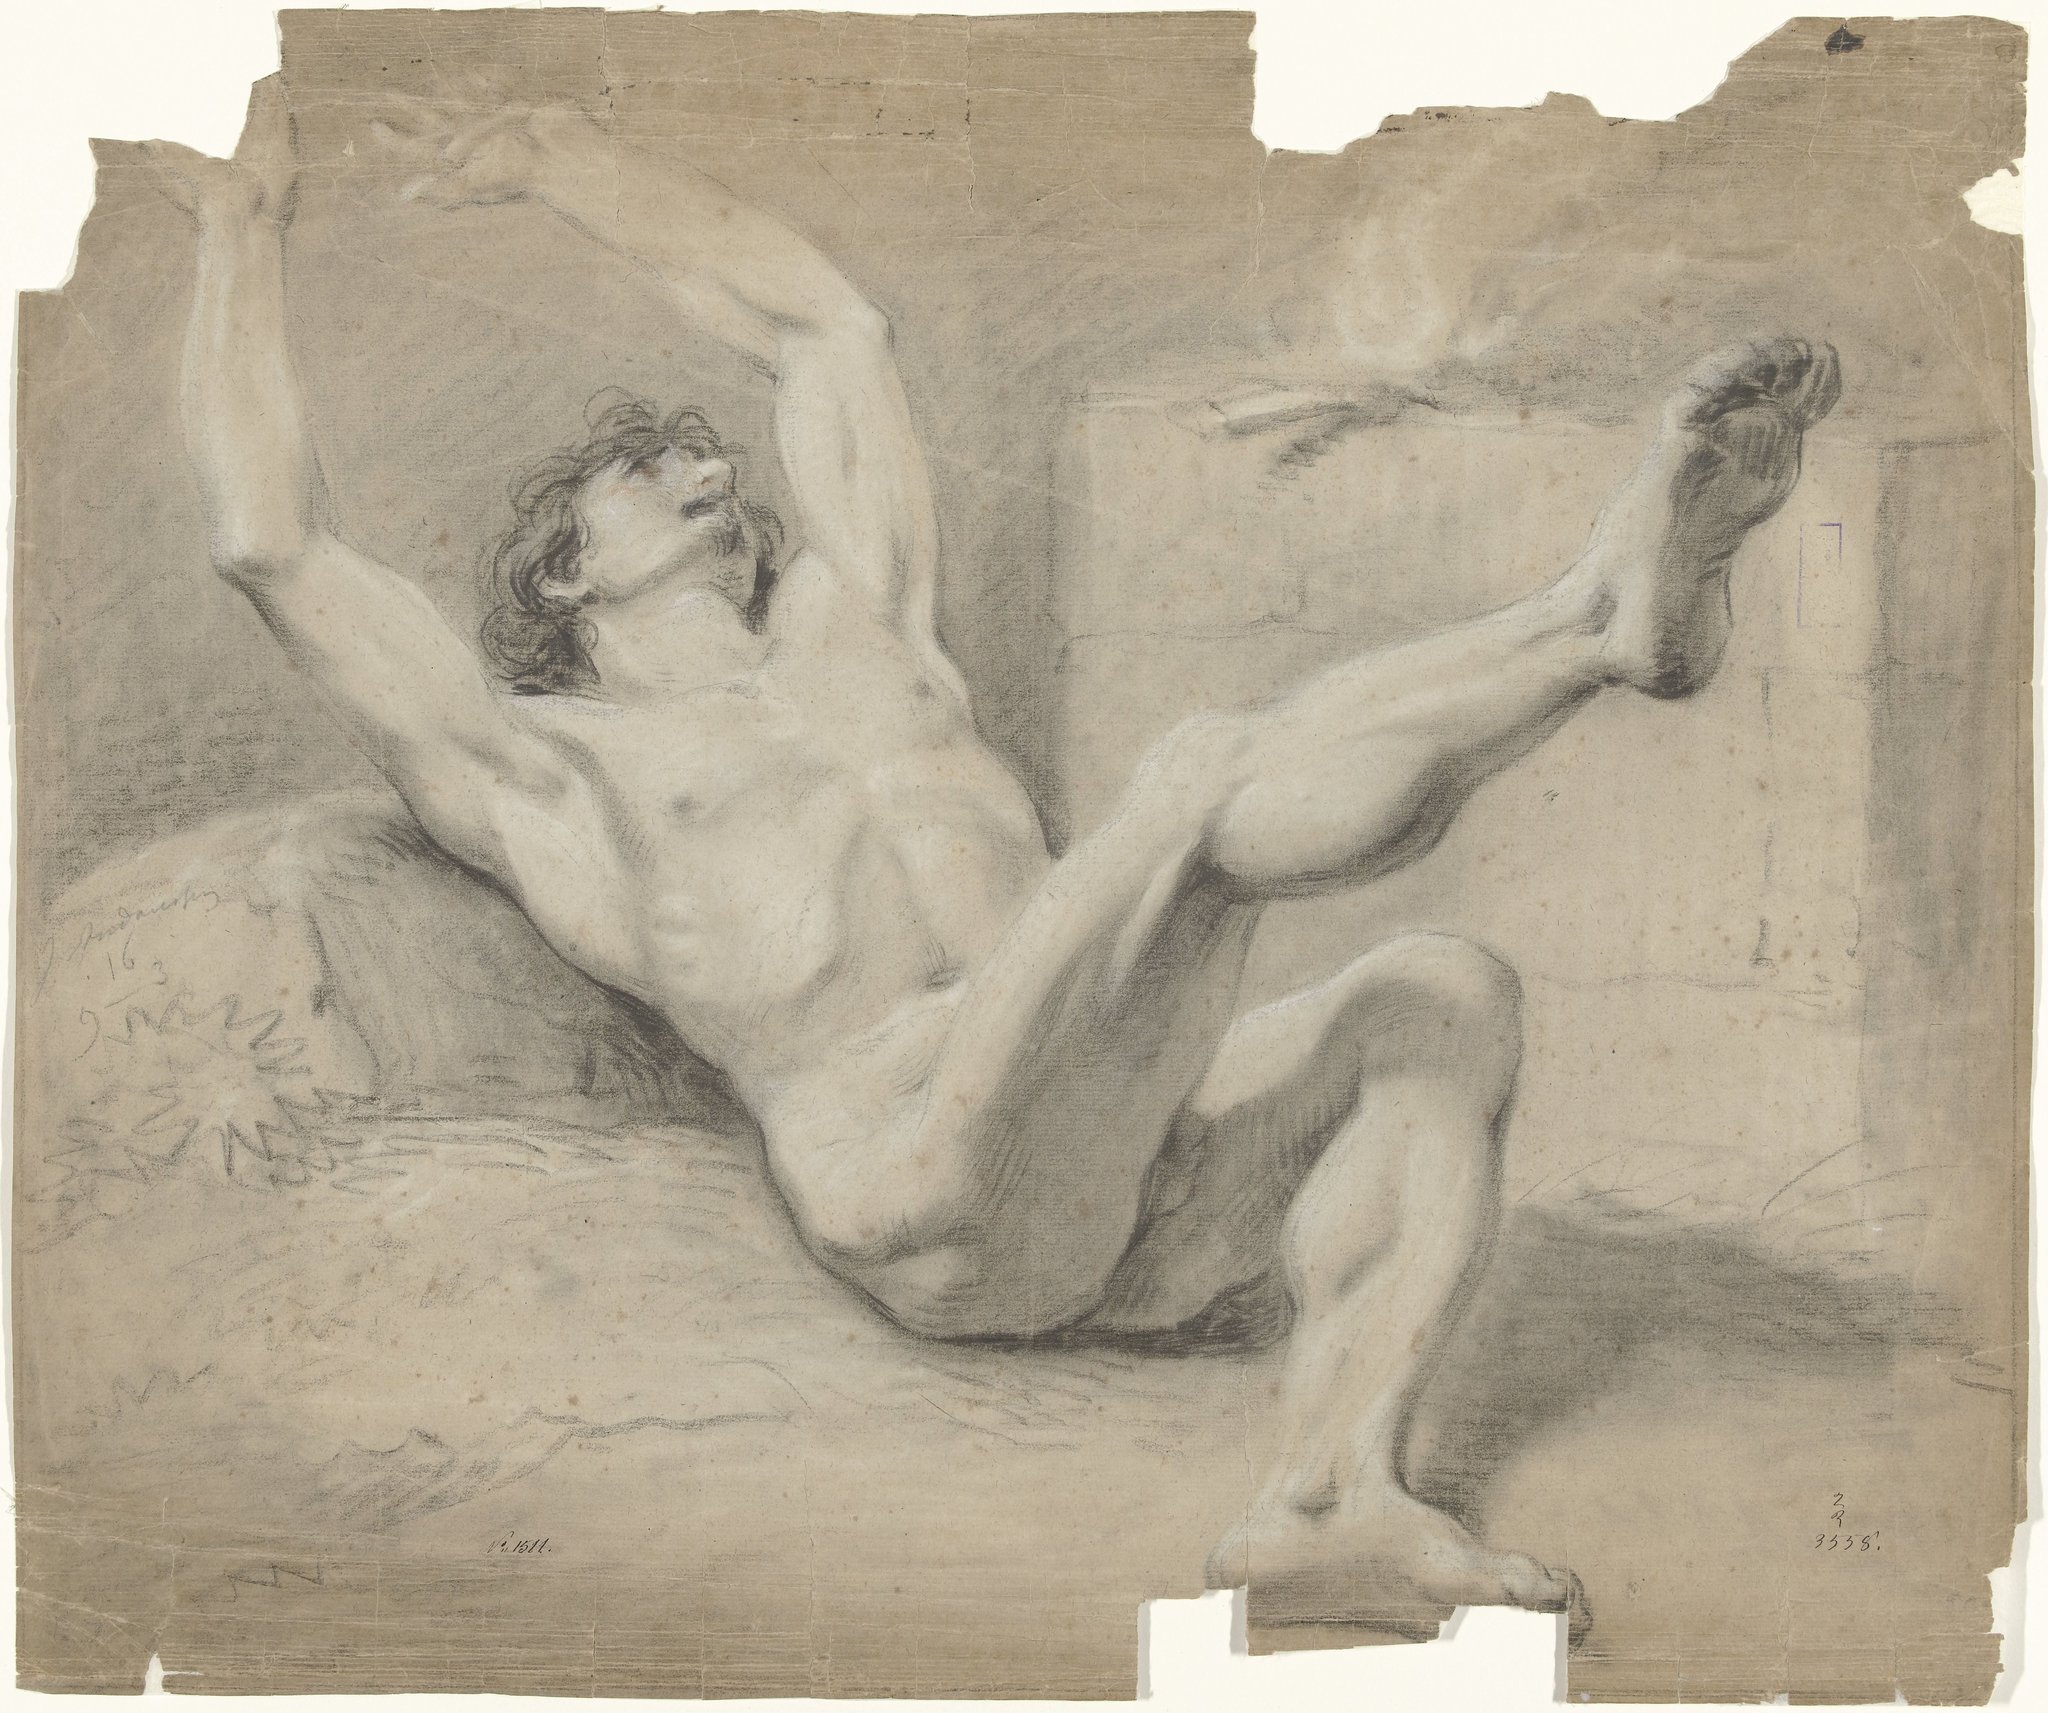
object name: drawing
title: Liggend mannelijk naakt, de armen naar achteren en het rechterbeen opgetild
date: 1793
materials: chalk, paper